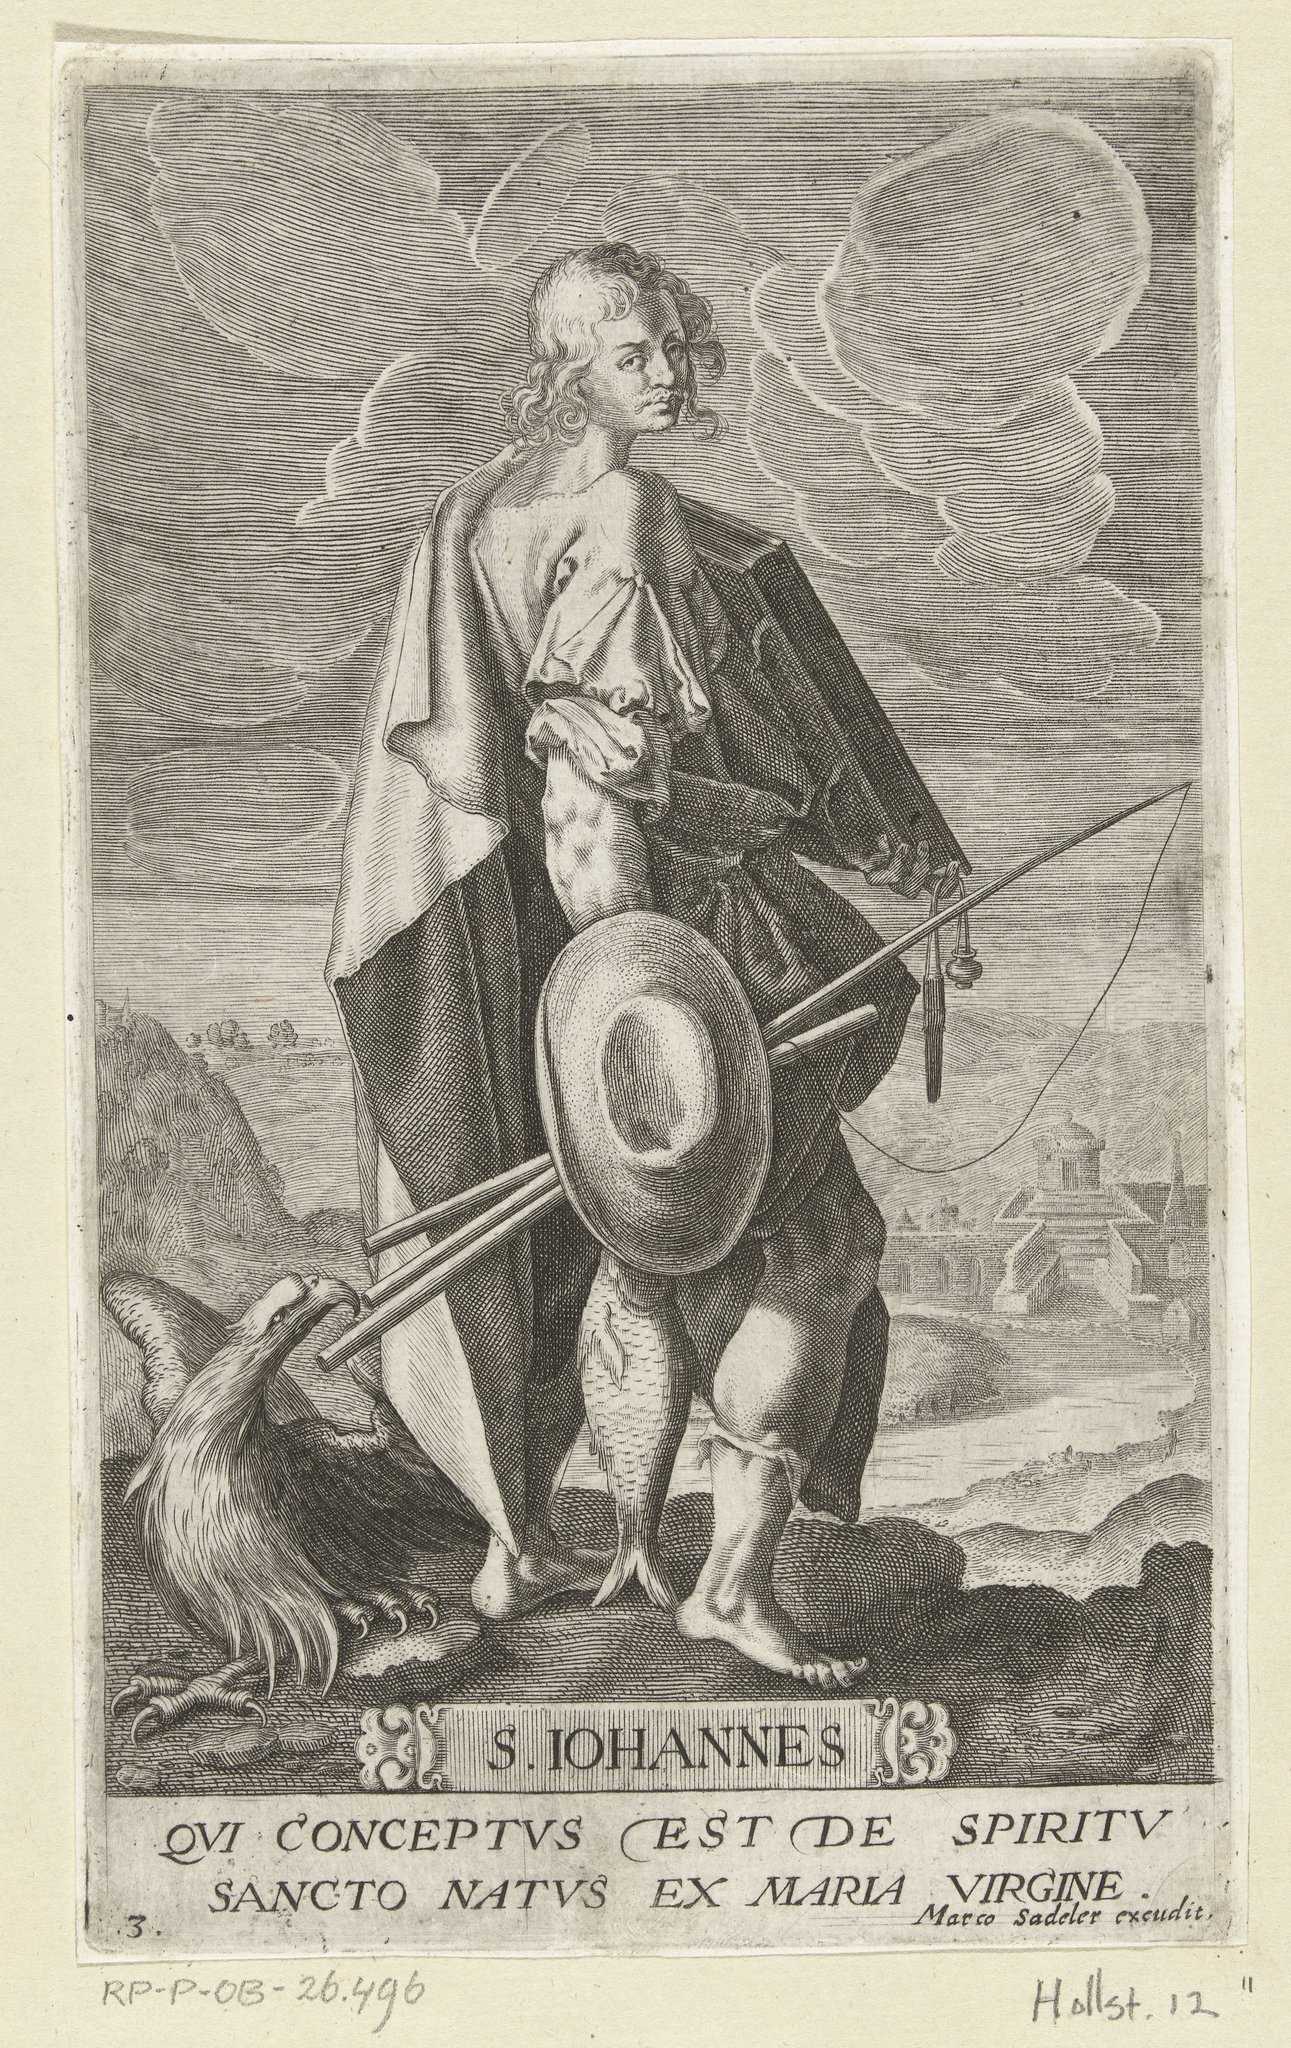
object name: print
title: Apostel en evangelist Johannes met vishengel en adelaar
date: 1591-1629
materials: paper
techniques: engraving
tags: the apostle john the evangelist; possible attributes: book, cauldron, chalice with snake, eagle, palm, scroll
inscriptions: collector's mark: Lugt 240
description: Apostel en evangelist Johannes met boek en vishengel met gevangen vis staat naast adelaar. Onder de voorstelling staat een Latijnse regel uit de apostolische geloofsbelijdenis.